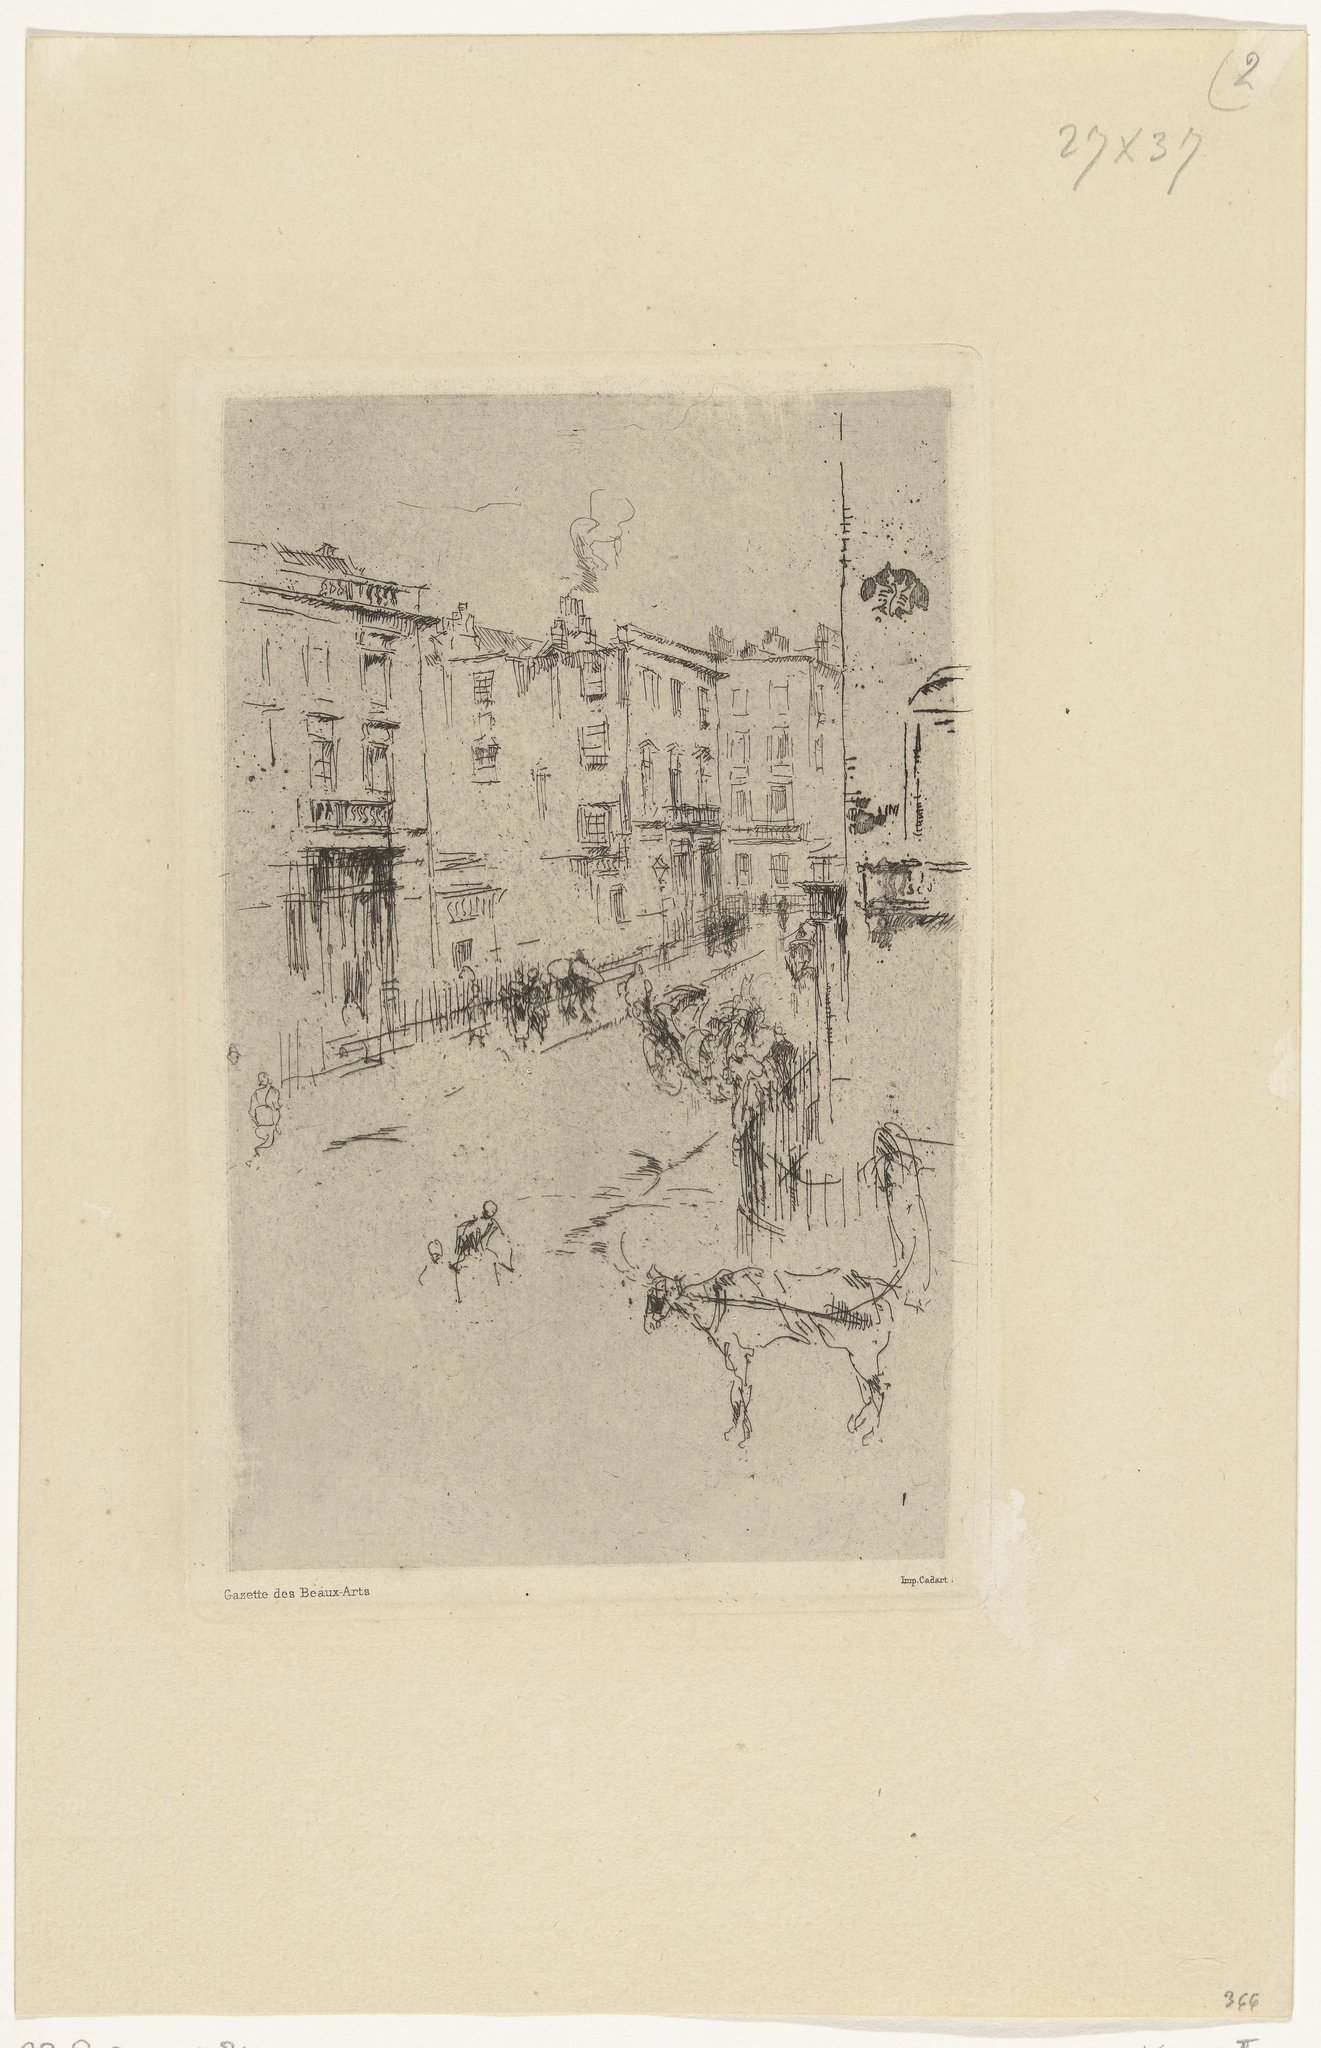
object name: print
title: Alderney street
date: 1880-1881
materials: paper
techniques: etching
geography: england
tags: street, london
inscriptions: collector's mark: ‘J. Frad. B.’, collector's mark: Lugt 2228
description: Verschenen in Gazette des Beaux-Arts, april 1881. Botke, K.